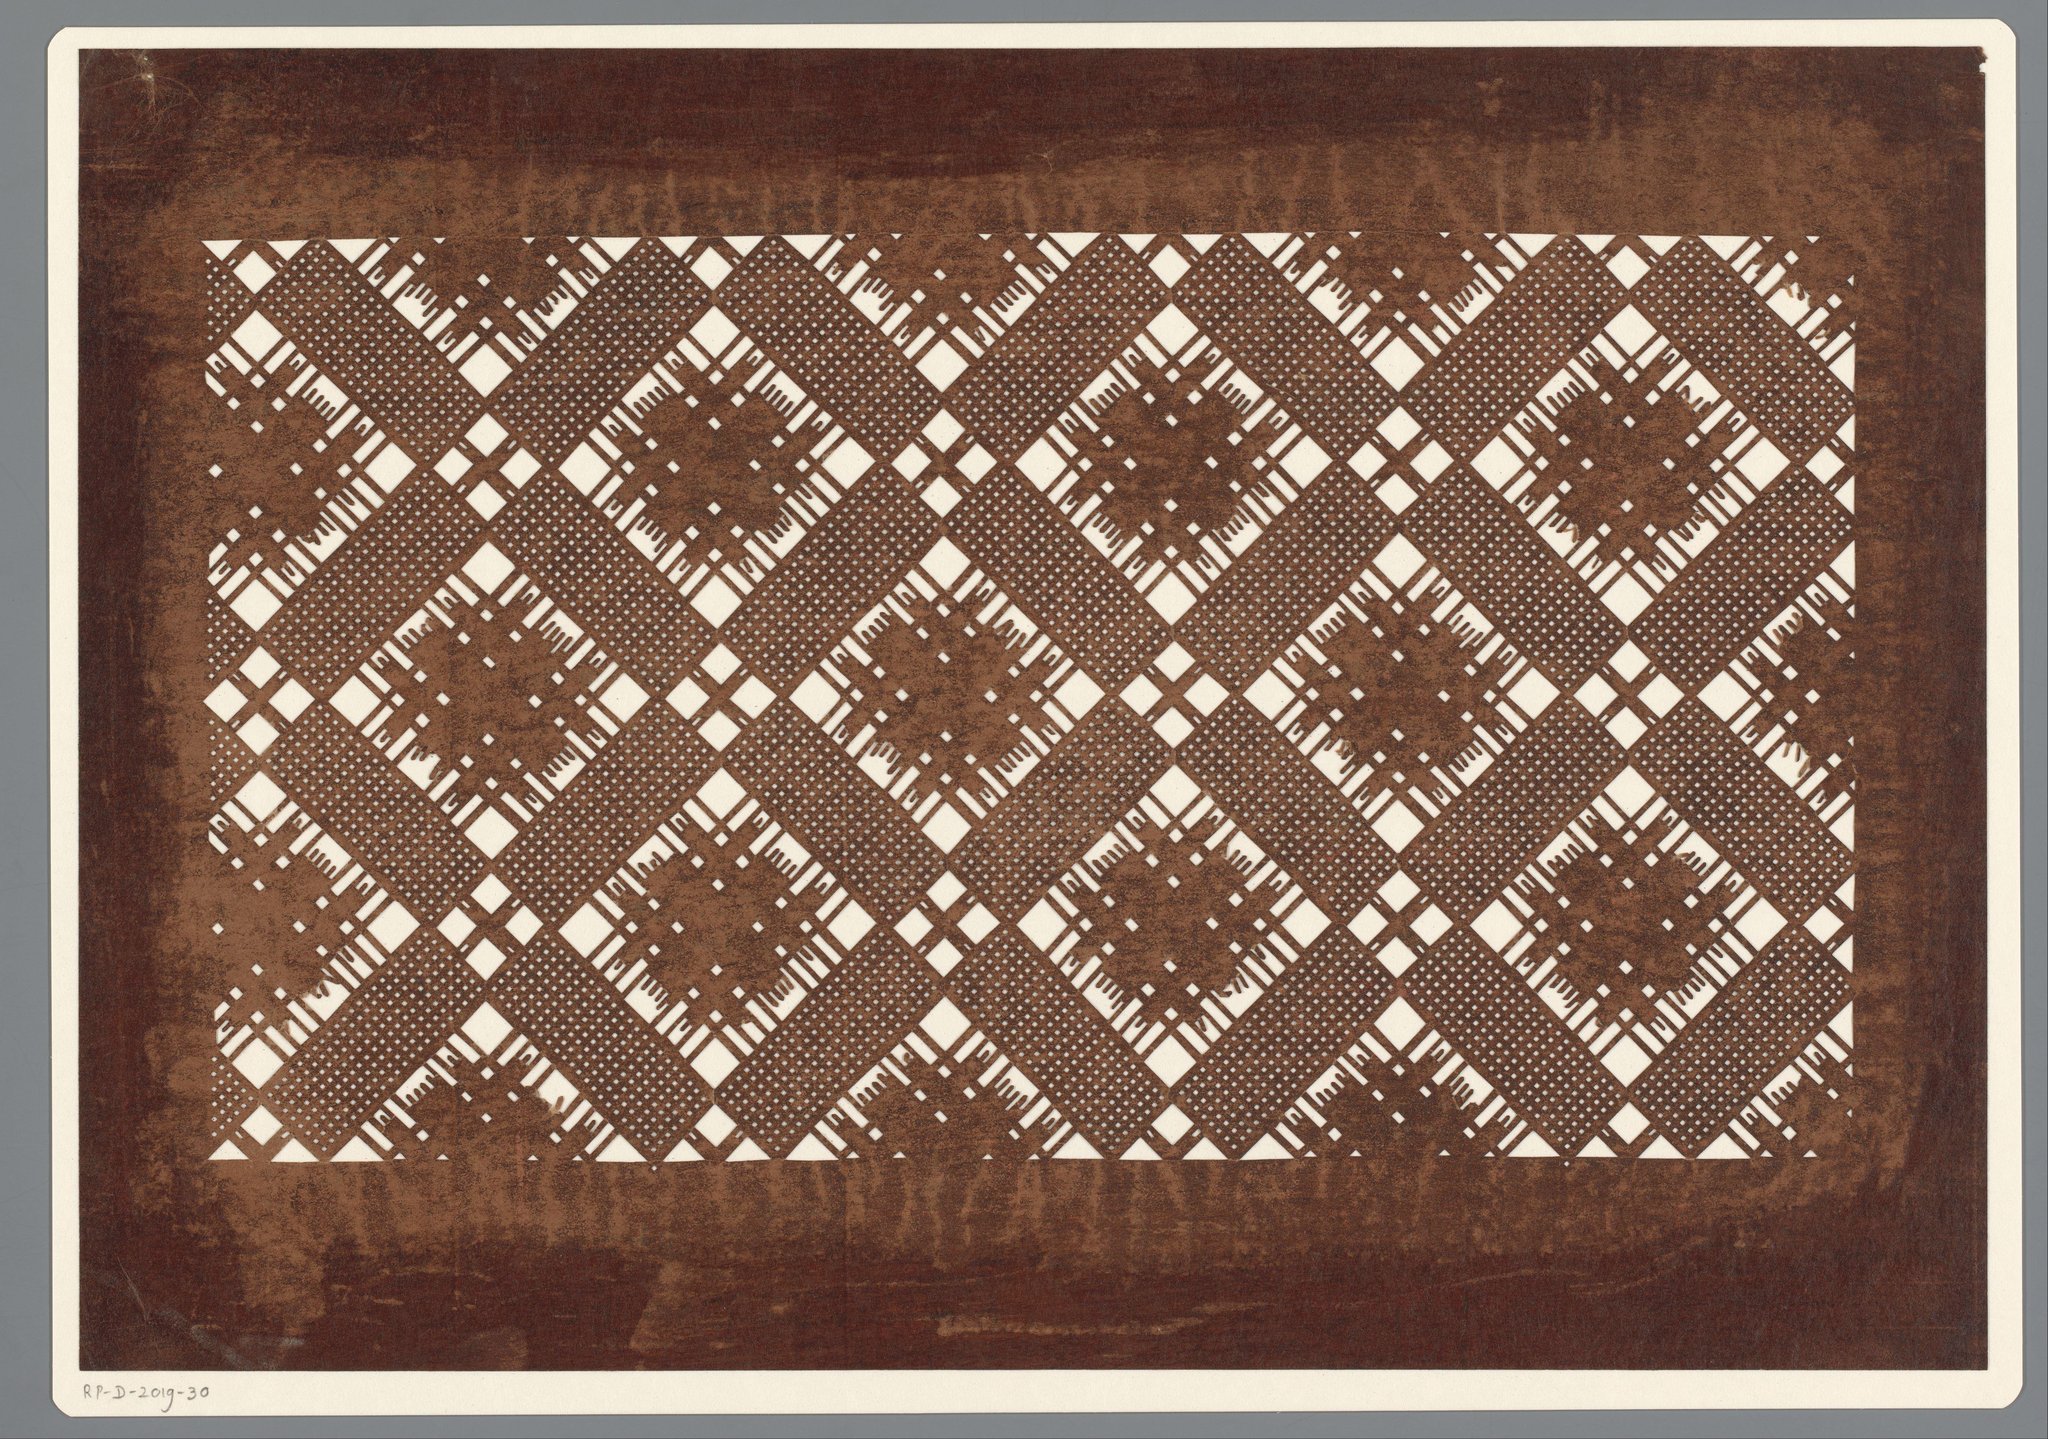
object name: katagami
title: Sjabloon met ruitenpatroon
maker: Anonymous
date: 1800-1909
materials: paper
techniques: cutting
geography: japan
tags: ornament ~ straight lines (right angles only)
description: Japanse sjabloon (katagami) met een diagonaal ruitenpatroon.